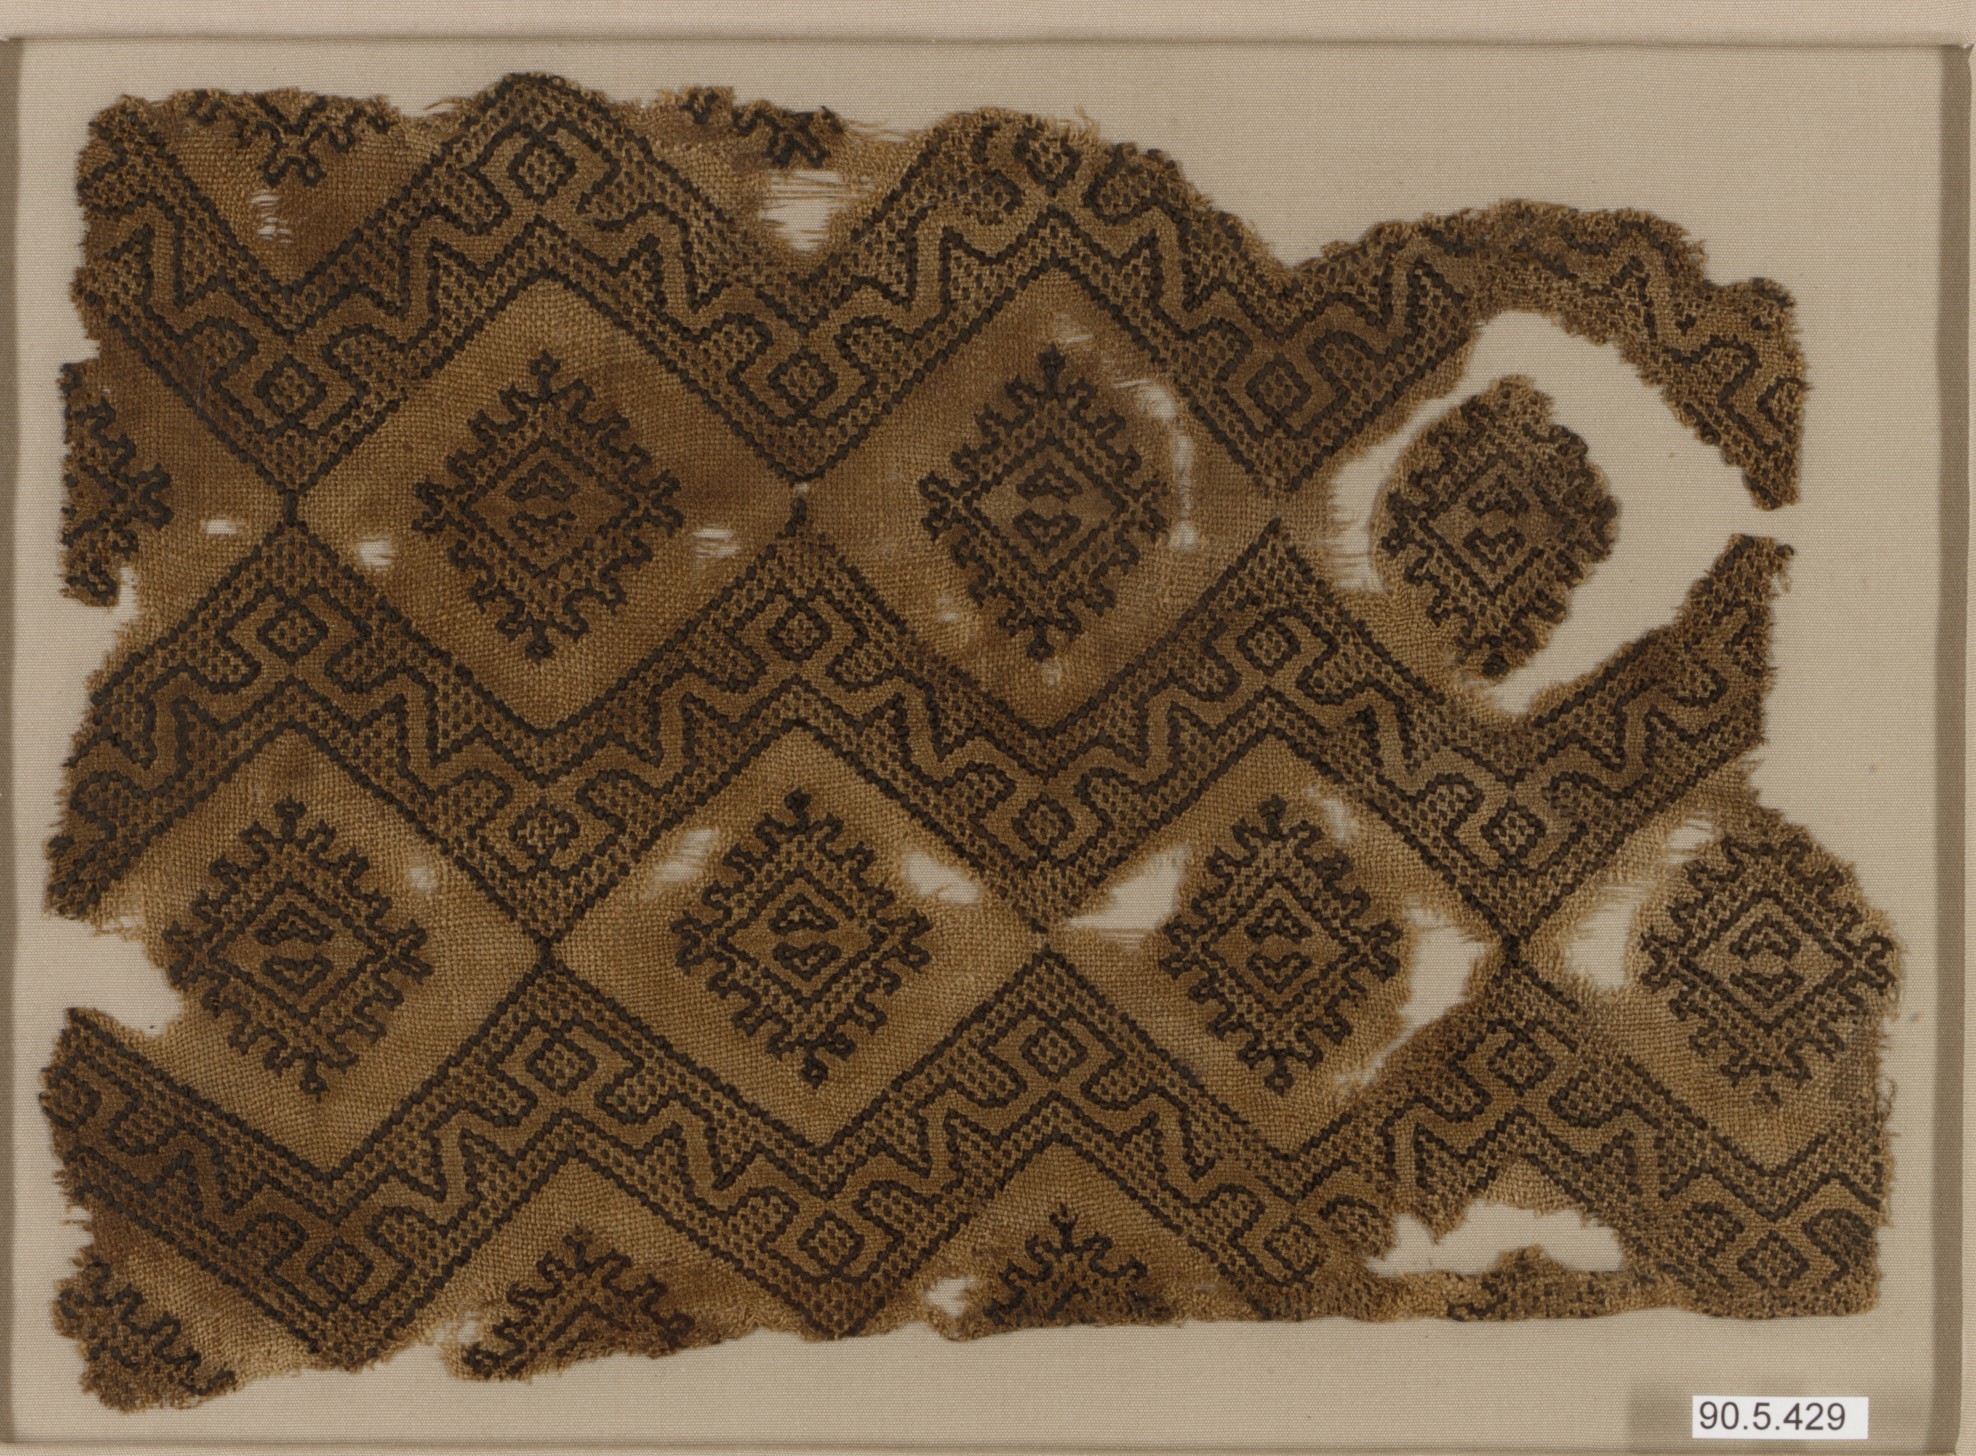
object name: textile fragment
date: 1301-1400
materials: linen, silk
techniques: brocade, weave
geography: egypt